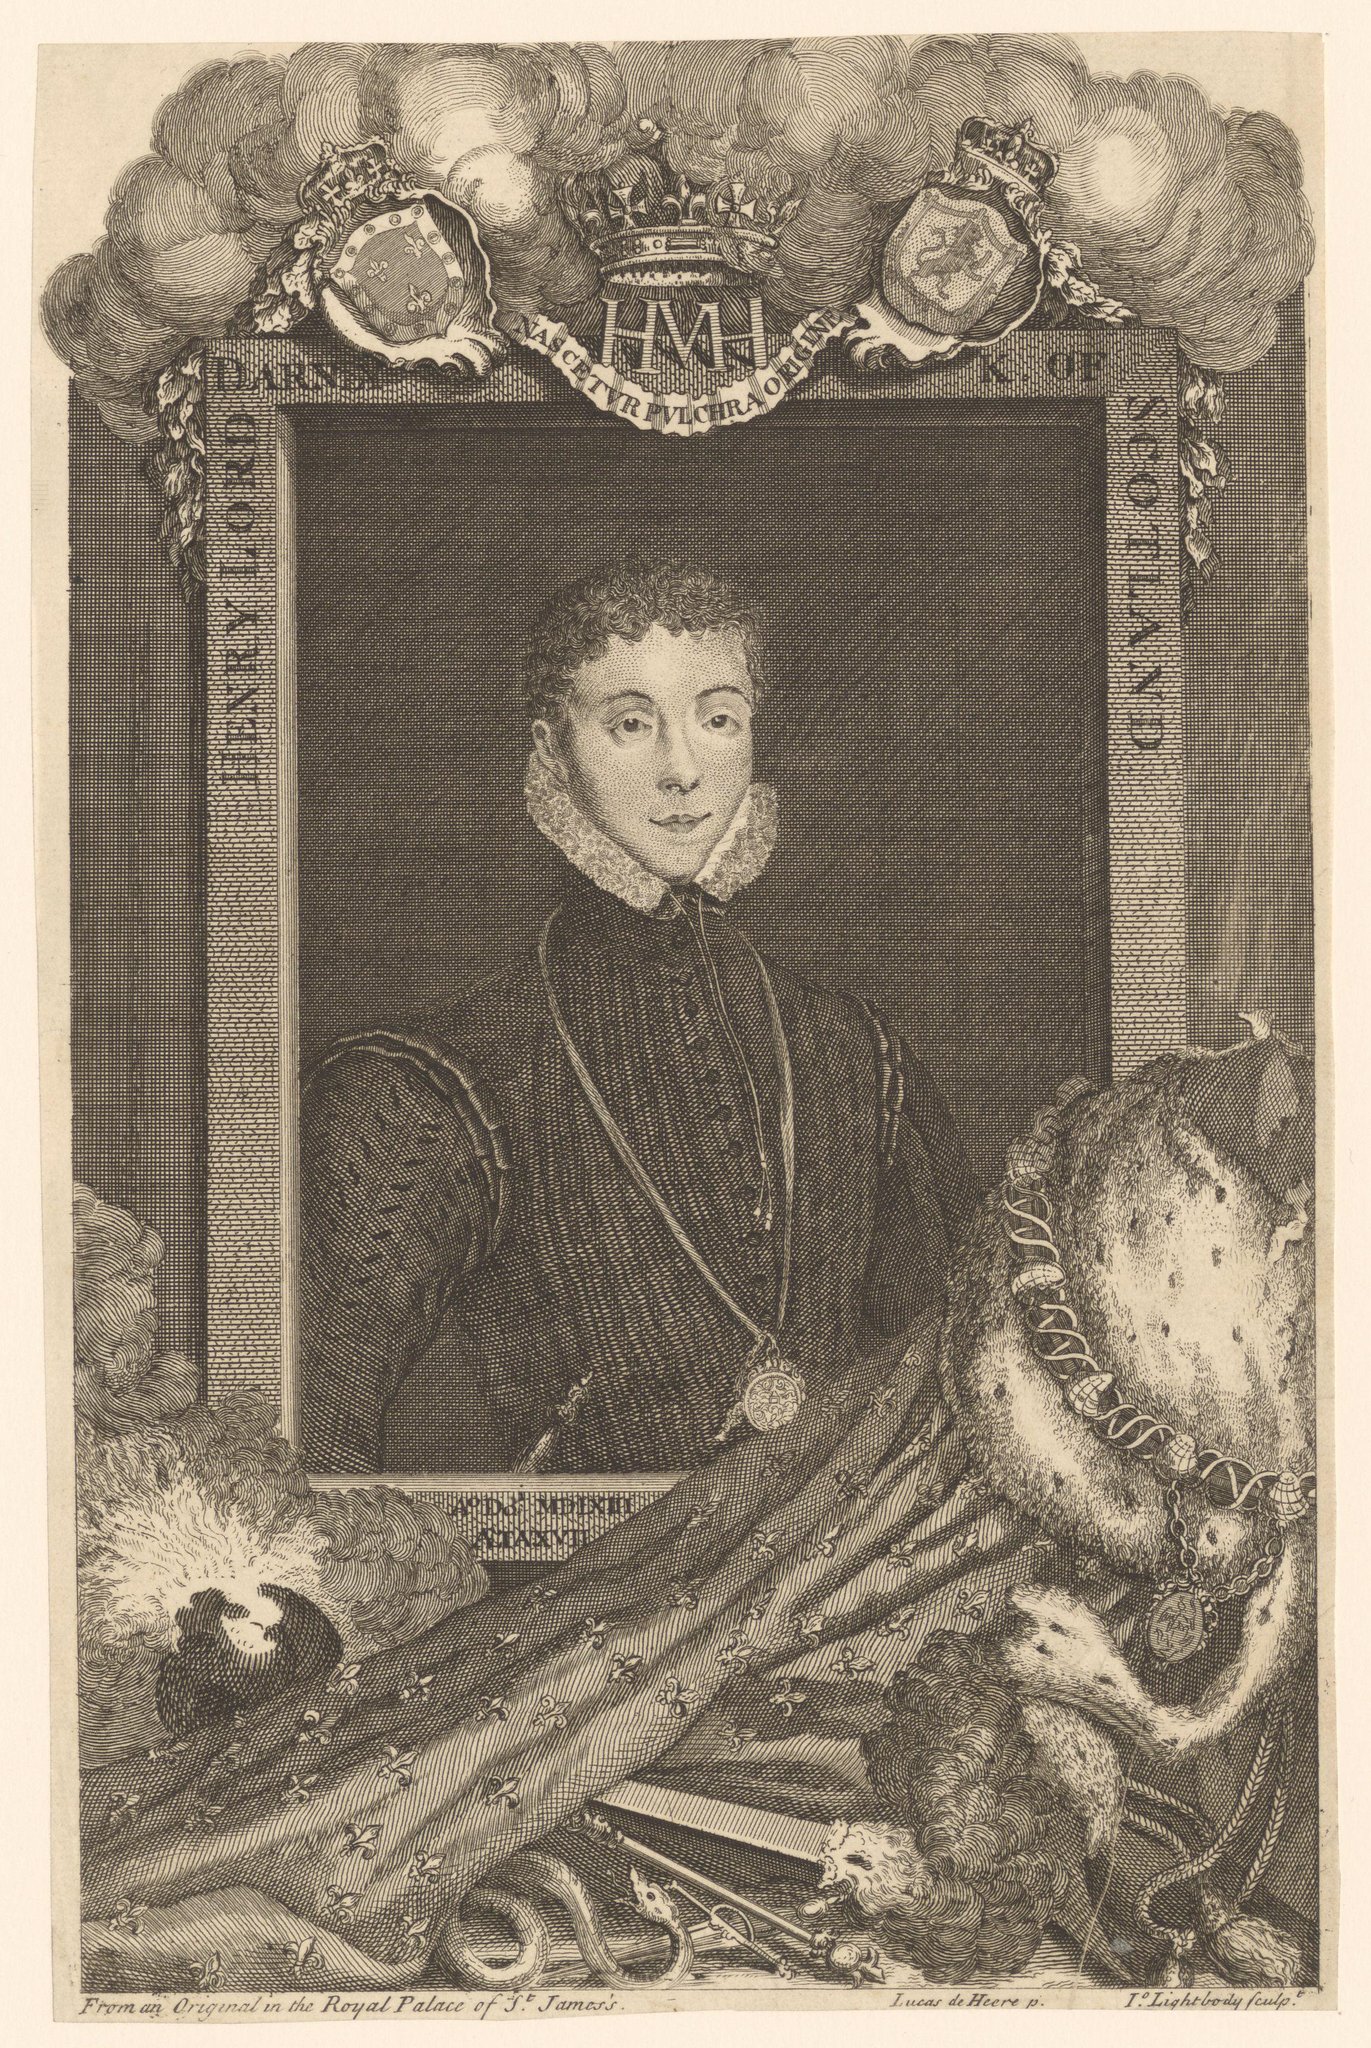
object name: print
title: Portret van Henry Stuart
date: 1555-1567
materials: paper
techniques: engraving, etching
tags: historical persons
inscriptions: collector's mark: Lugt 2228